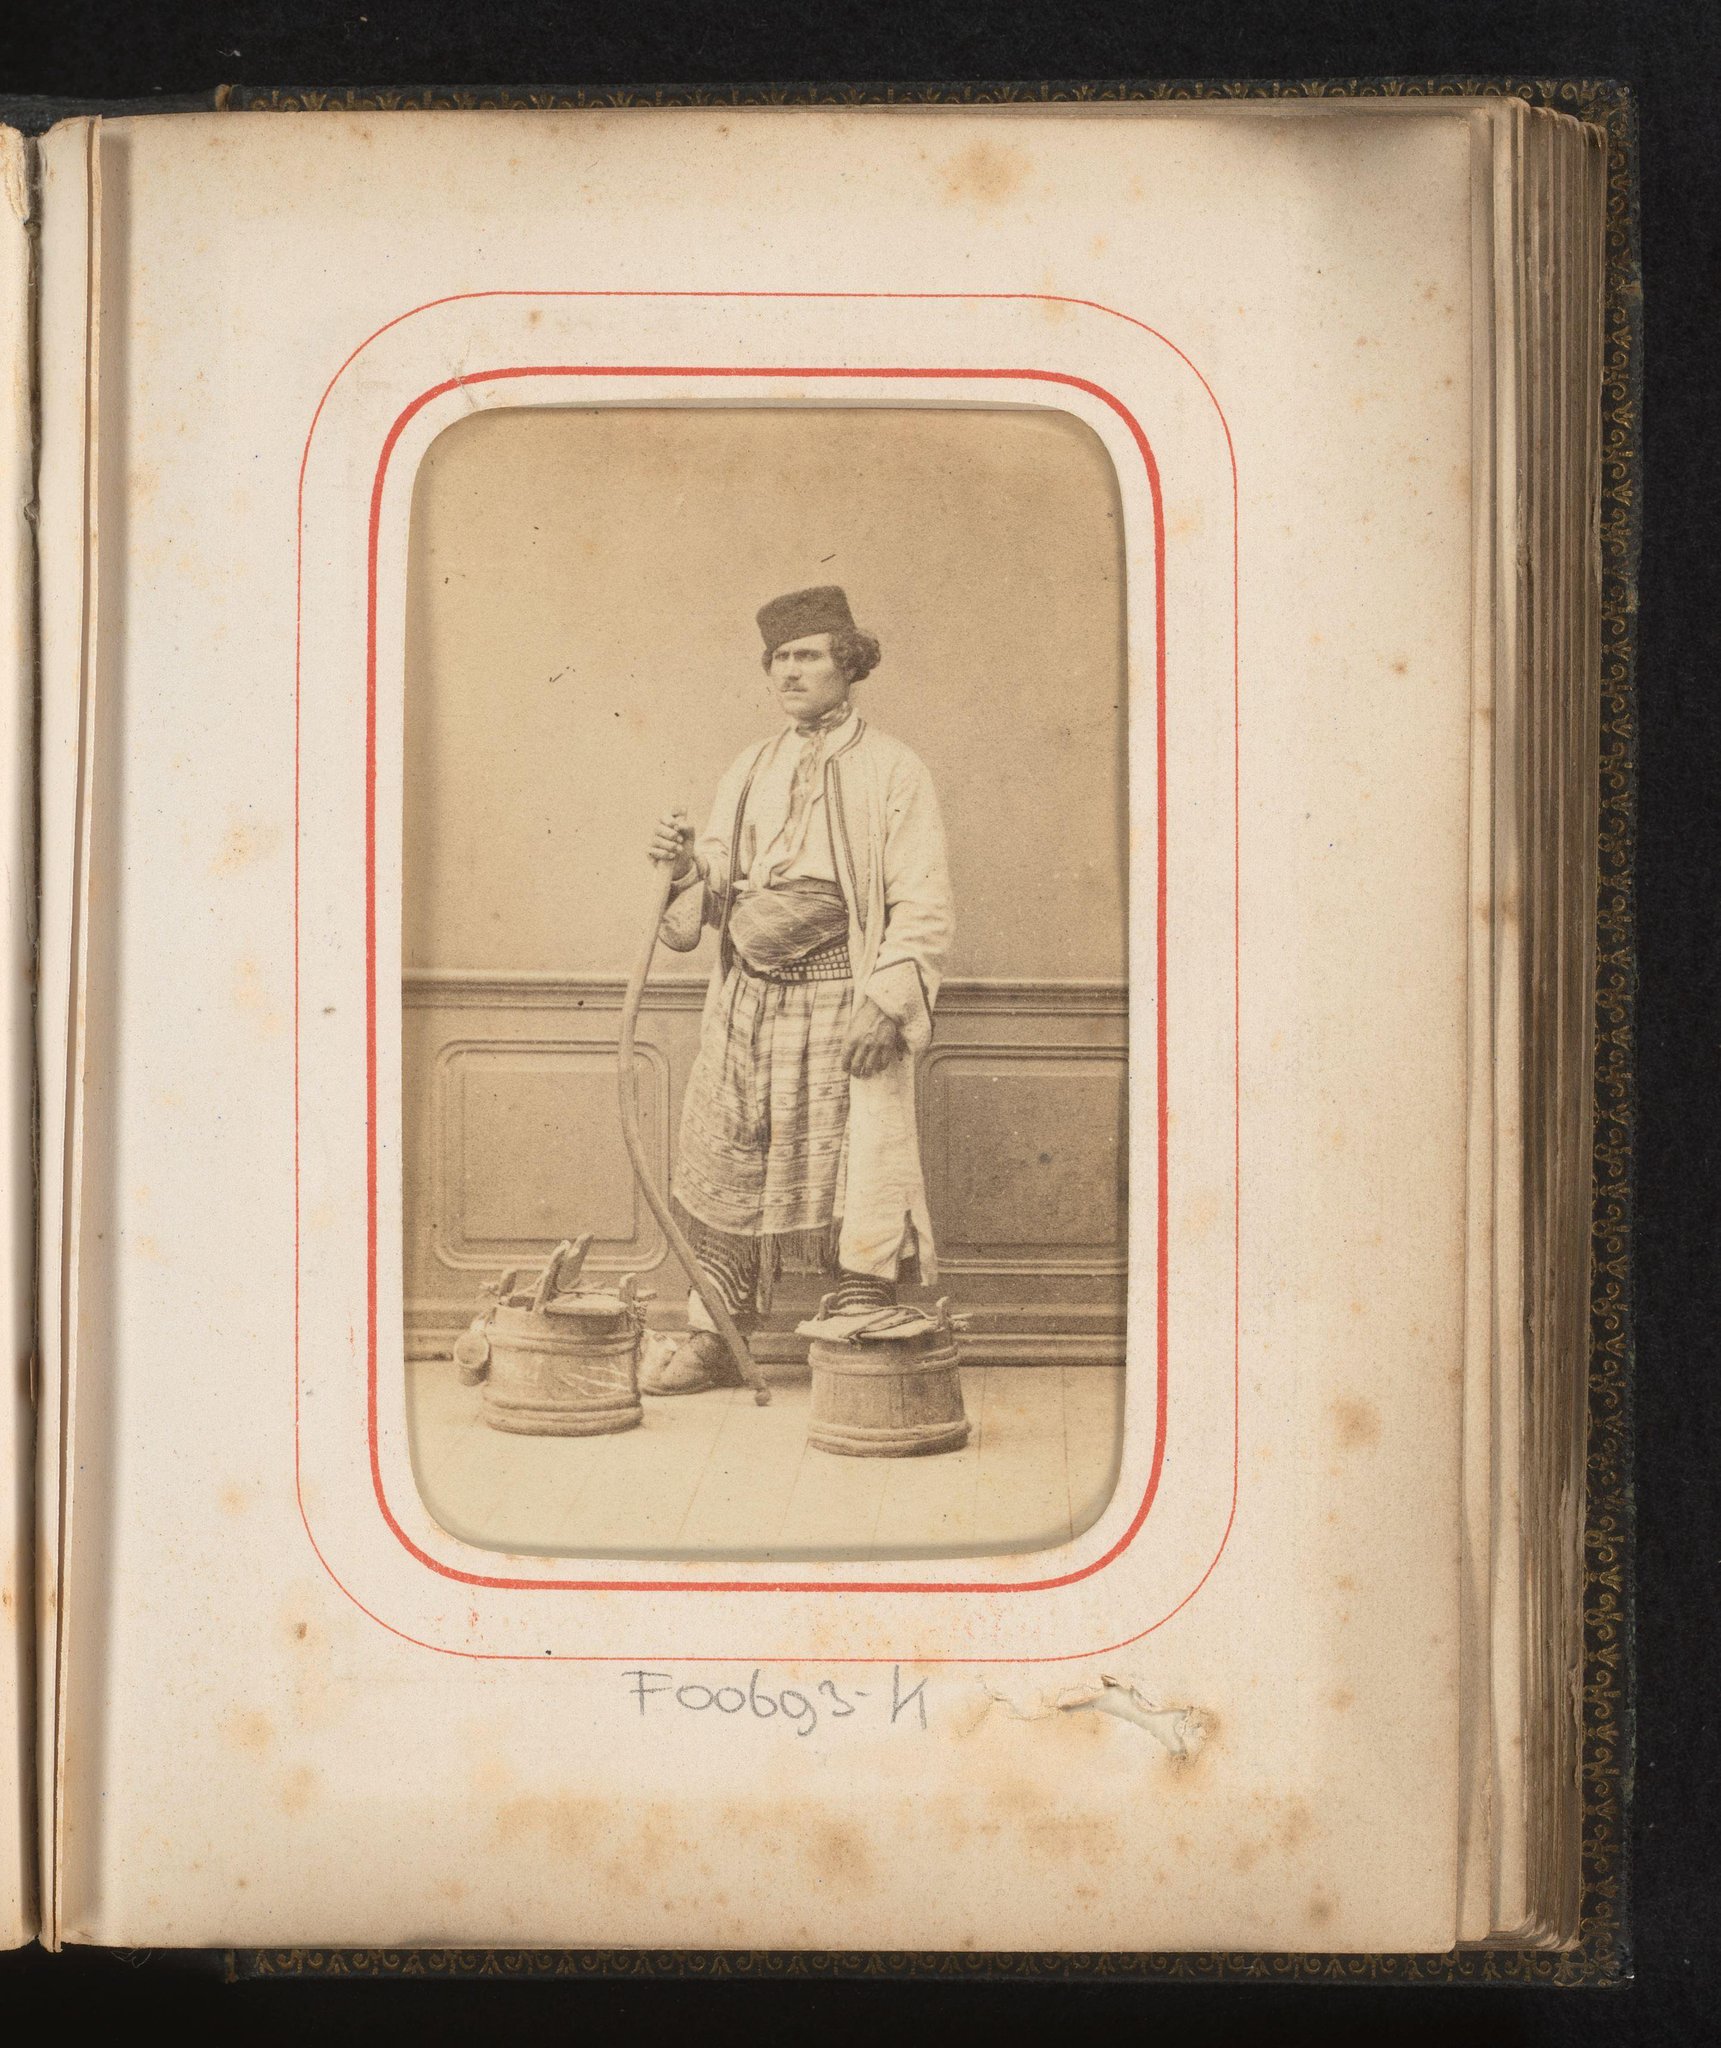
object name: photograph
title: Portret van een man in Roemeense klederdracht met juk en houten emmers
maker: carol popp de szathmari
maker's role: fotograaf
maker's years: 1812-1887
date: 1870-1890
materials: cardboard, photographic support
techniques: albumen print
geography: bucharest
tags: historical persons, carrying something with yoke, folk costume, regional costume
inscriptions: inscription: ‘CHARLES SZATHMARI/ Peintre et Photographe de la Cour/ DE SALE PRINCE REGNANT/ des Principautées unies Roumaines./ (...)/ BUCAREST.’